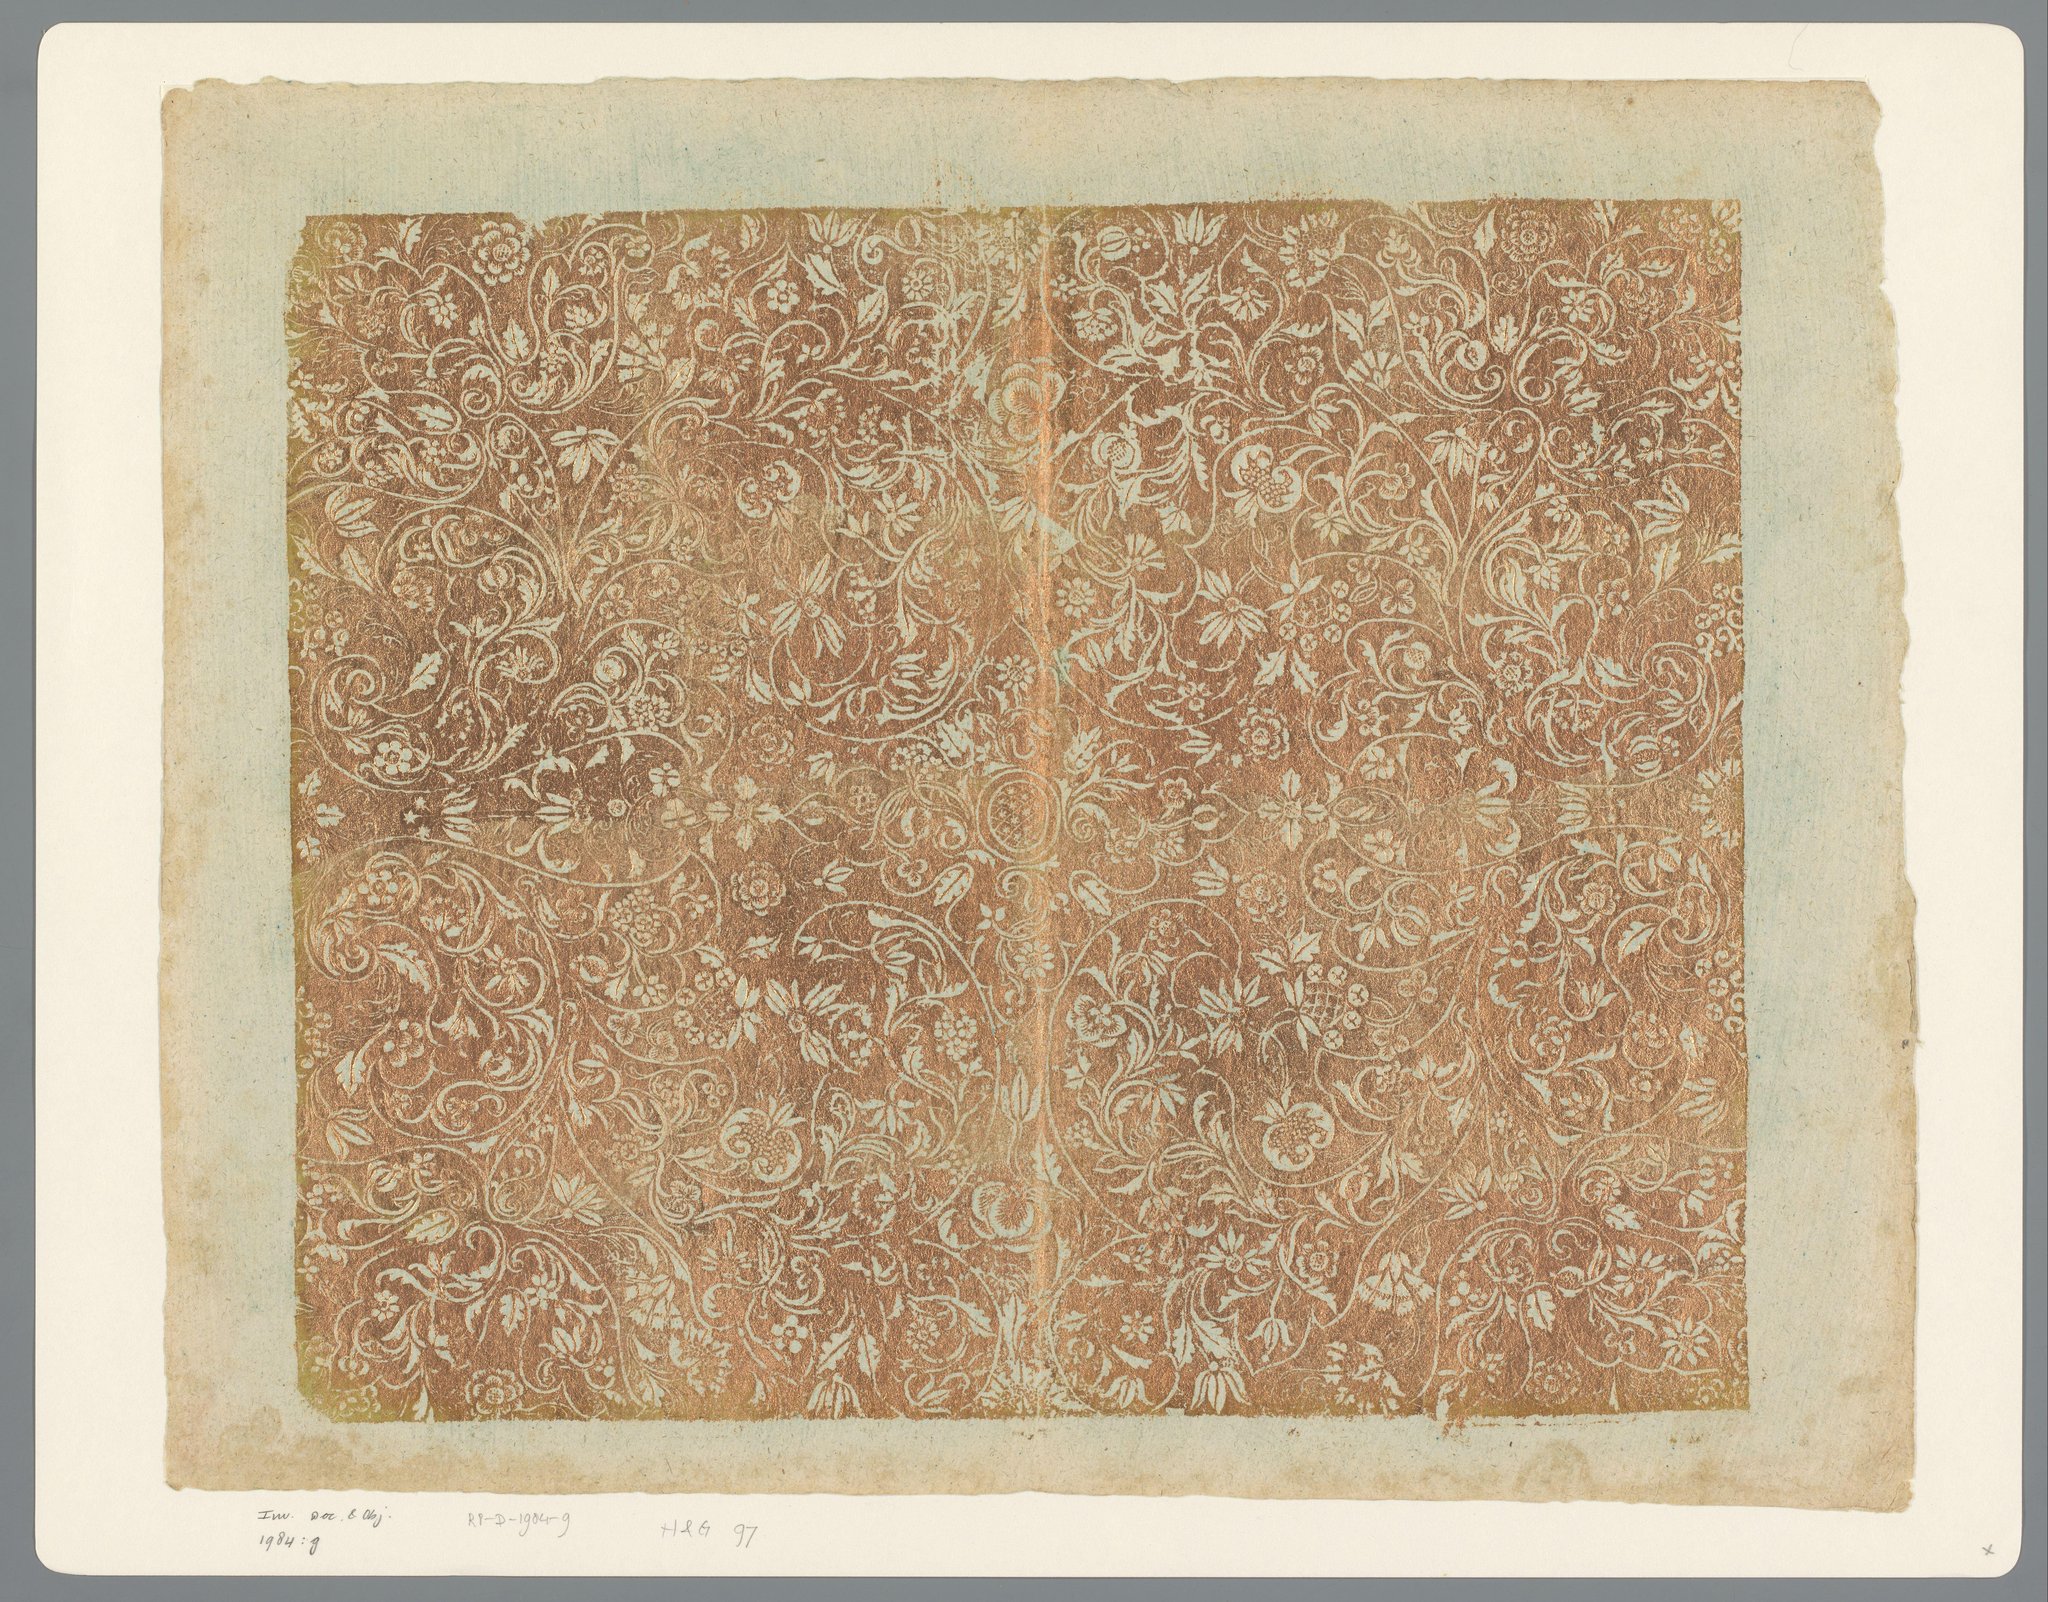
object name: brocade paper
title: Blad met ranken met bloemen en vruchten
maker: Anonymous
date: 1750-1800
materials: gold leaf, paint, paper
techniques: relief print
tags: ornament derived from plant forms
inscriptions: collector's mark: Lugt 2760, collector's mark: Lugt 2228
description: Blad met ranken met bloemen en vruchten.